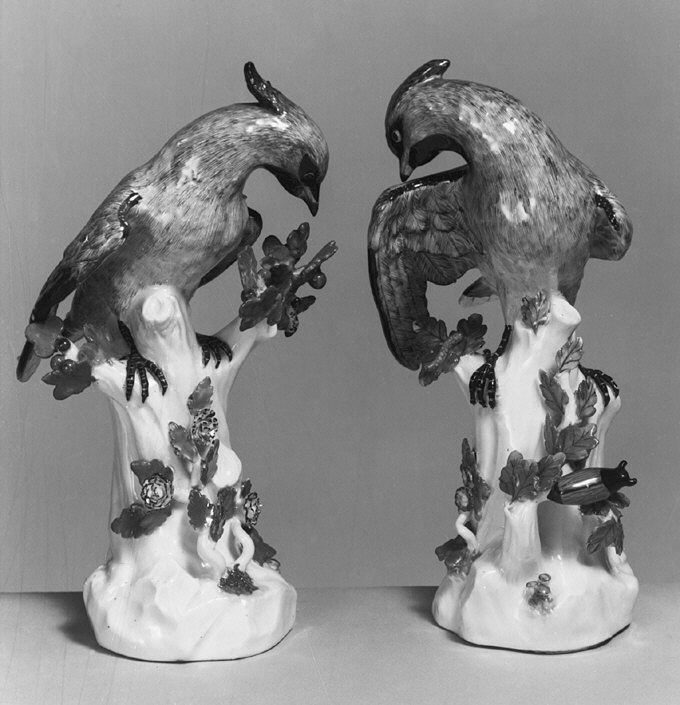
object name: figure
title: Waxwing (one of a pair)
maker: meissen manufactory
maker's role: manufactory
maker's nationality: german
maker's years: 1710-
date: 1741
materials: hard paste porcelain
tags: birds,flowers,leaves